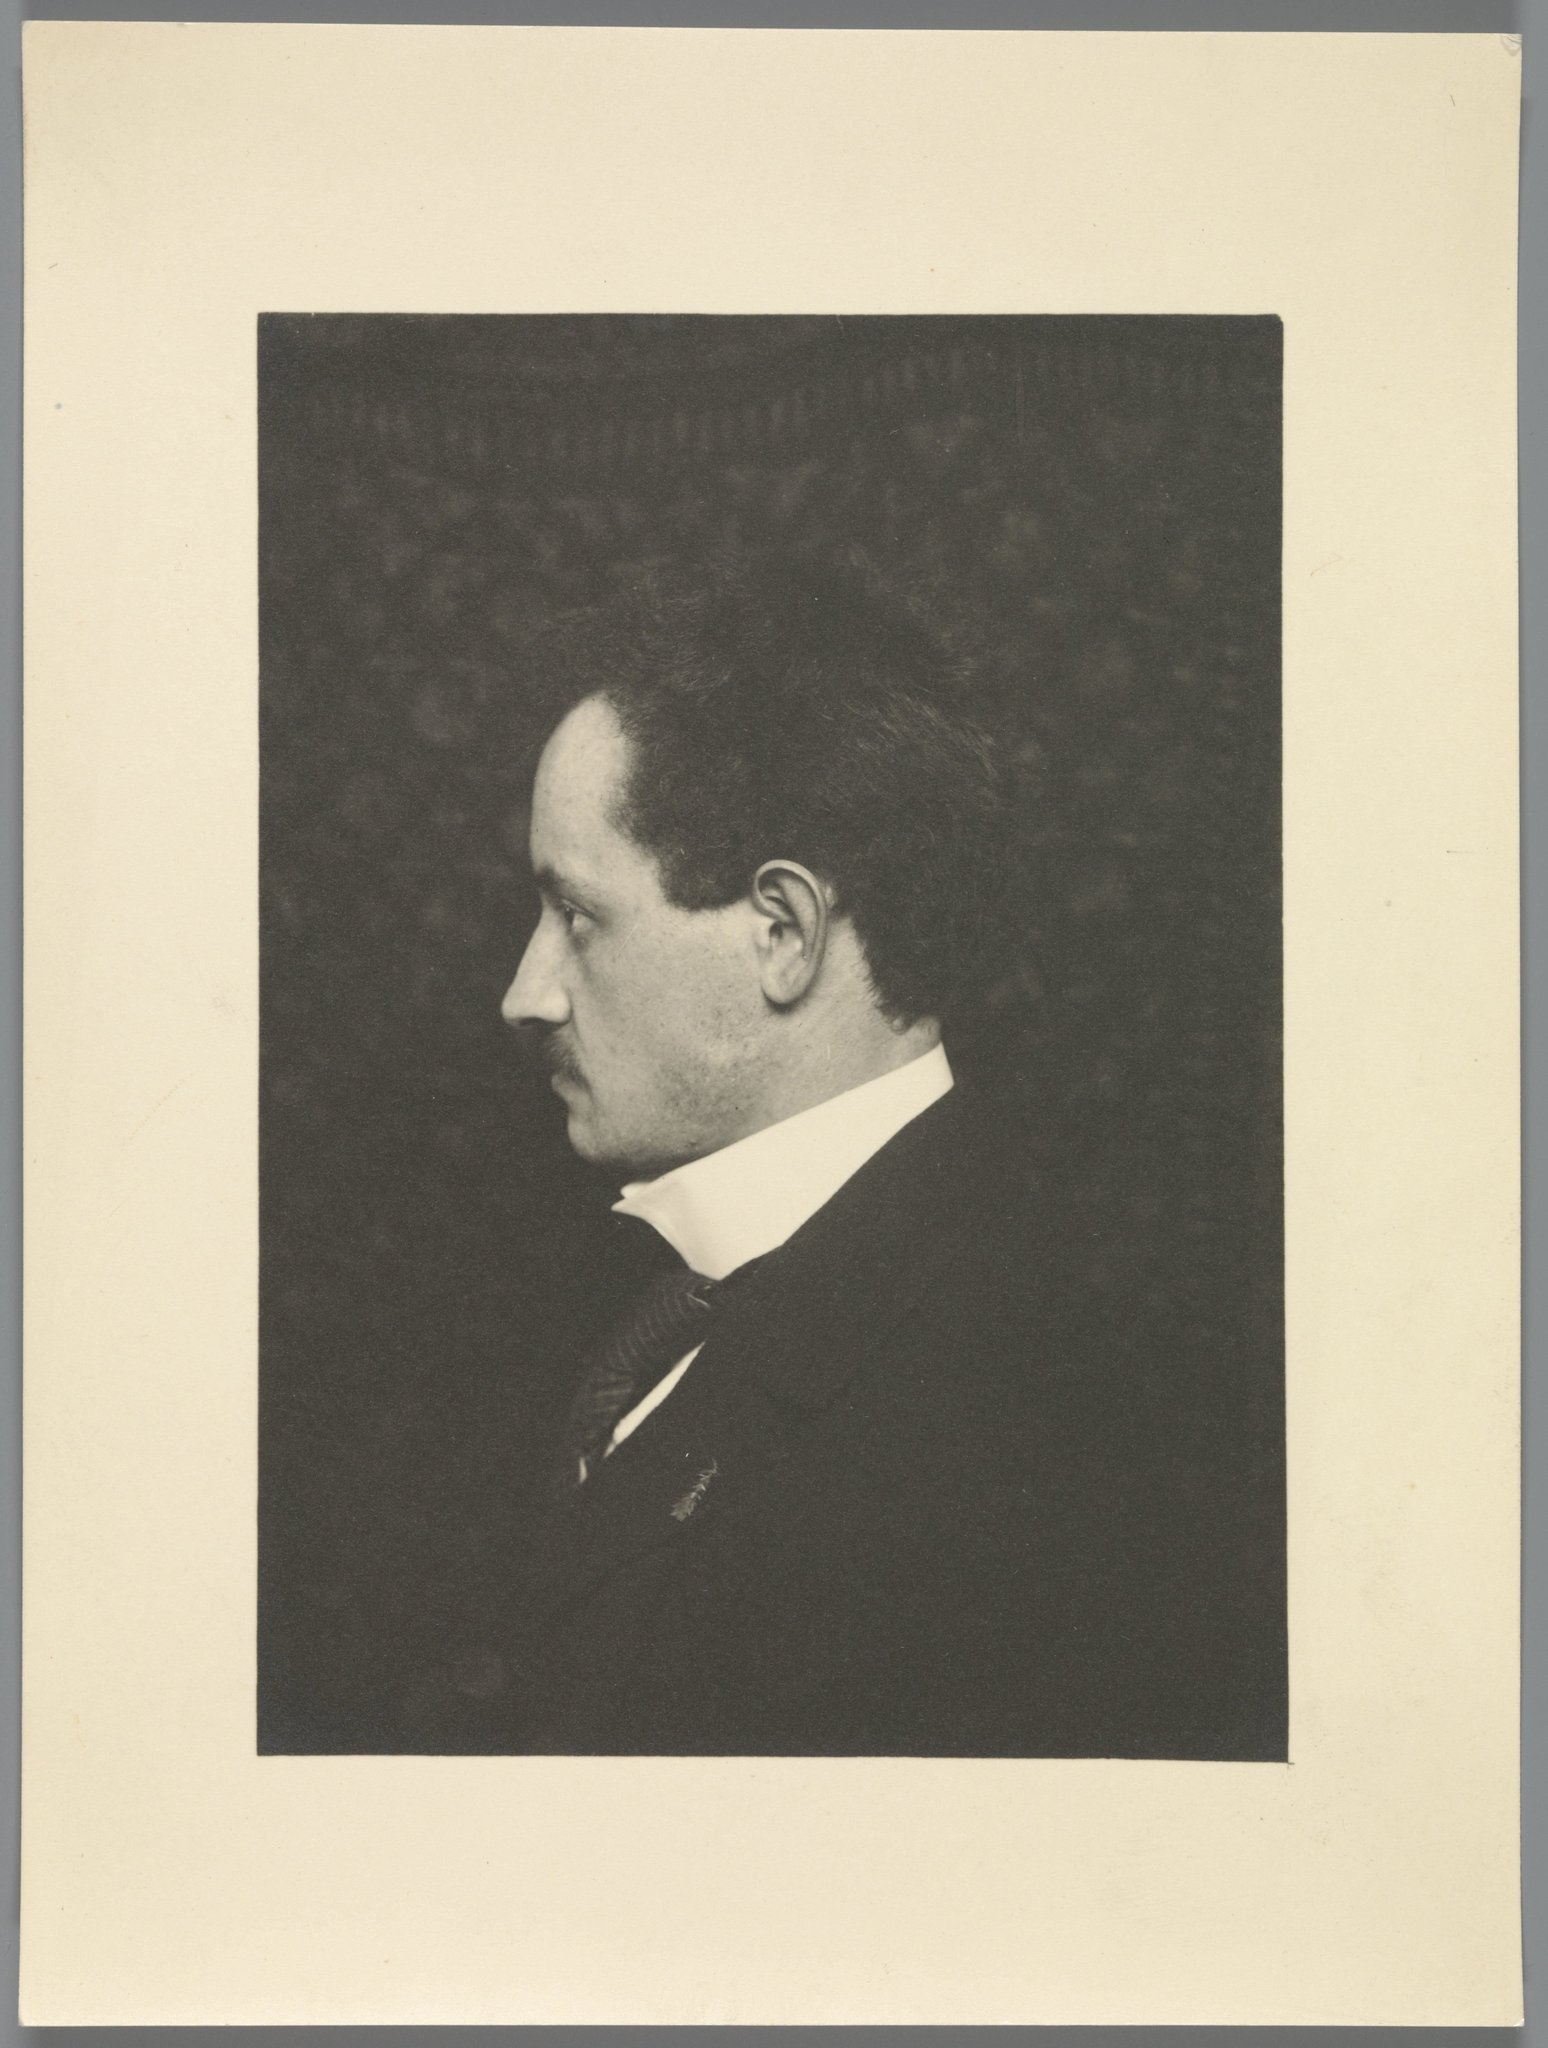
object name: photograph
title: Reproductie naar een foto van Willem Witsen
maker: Anonymous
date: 1860-1915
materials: paper, photographic support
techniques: gelatin silver print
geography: netherlands